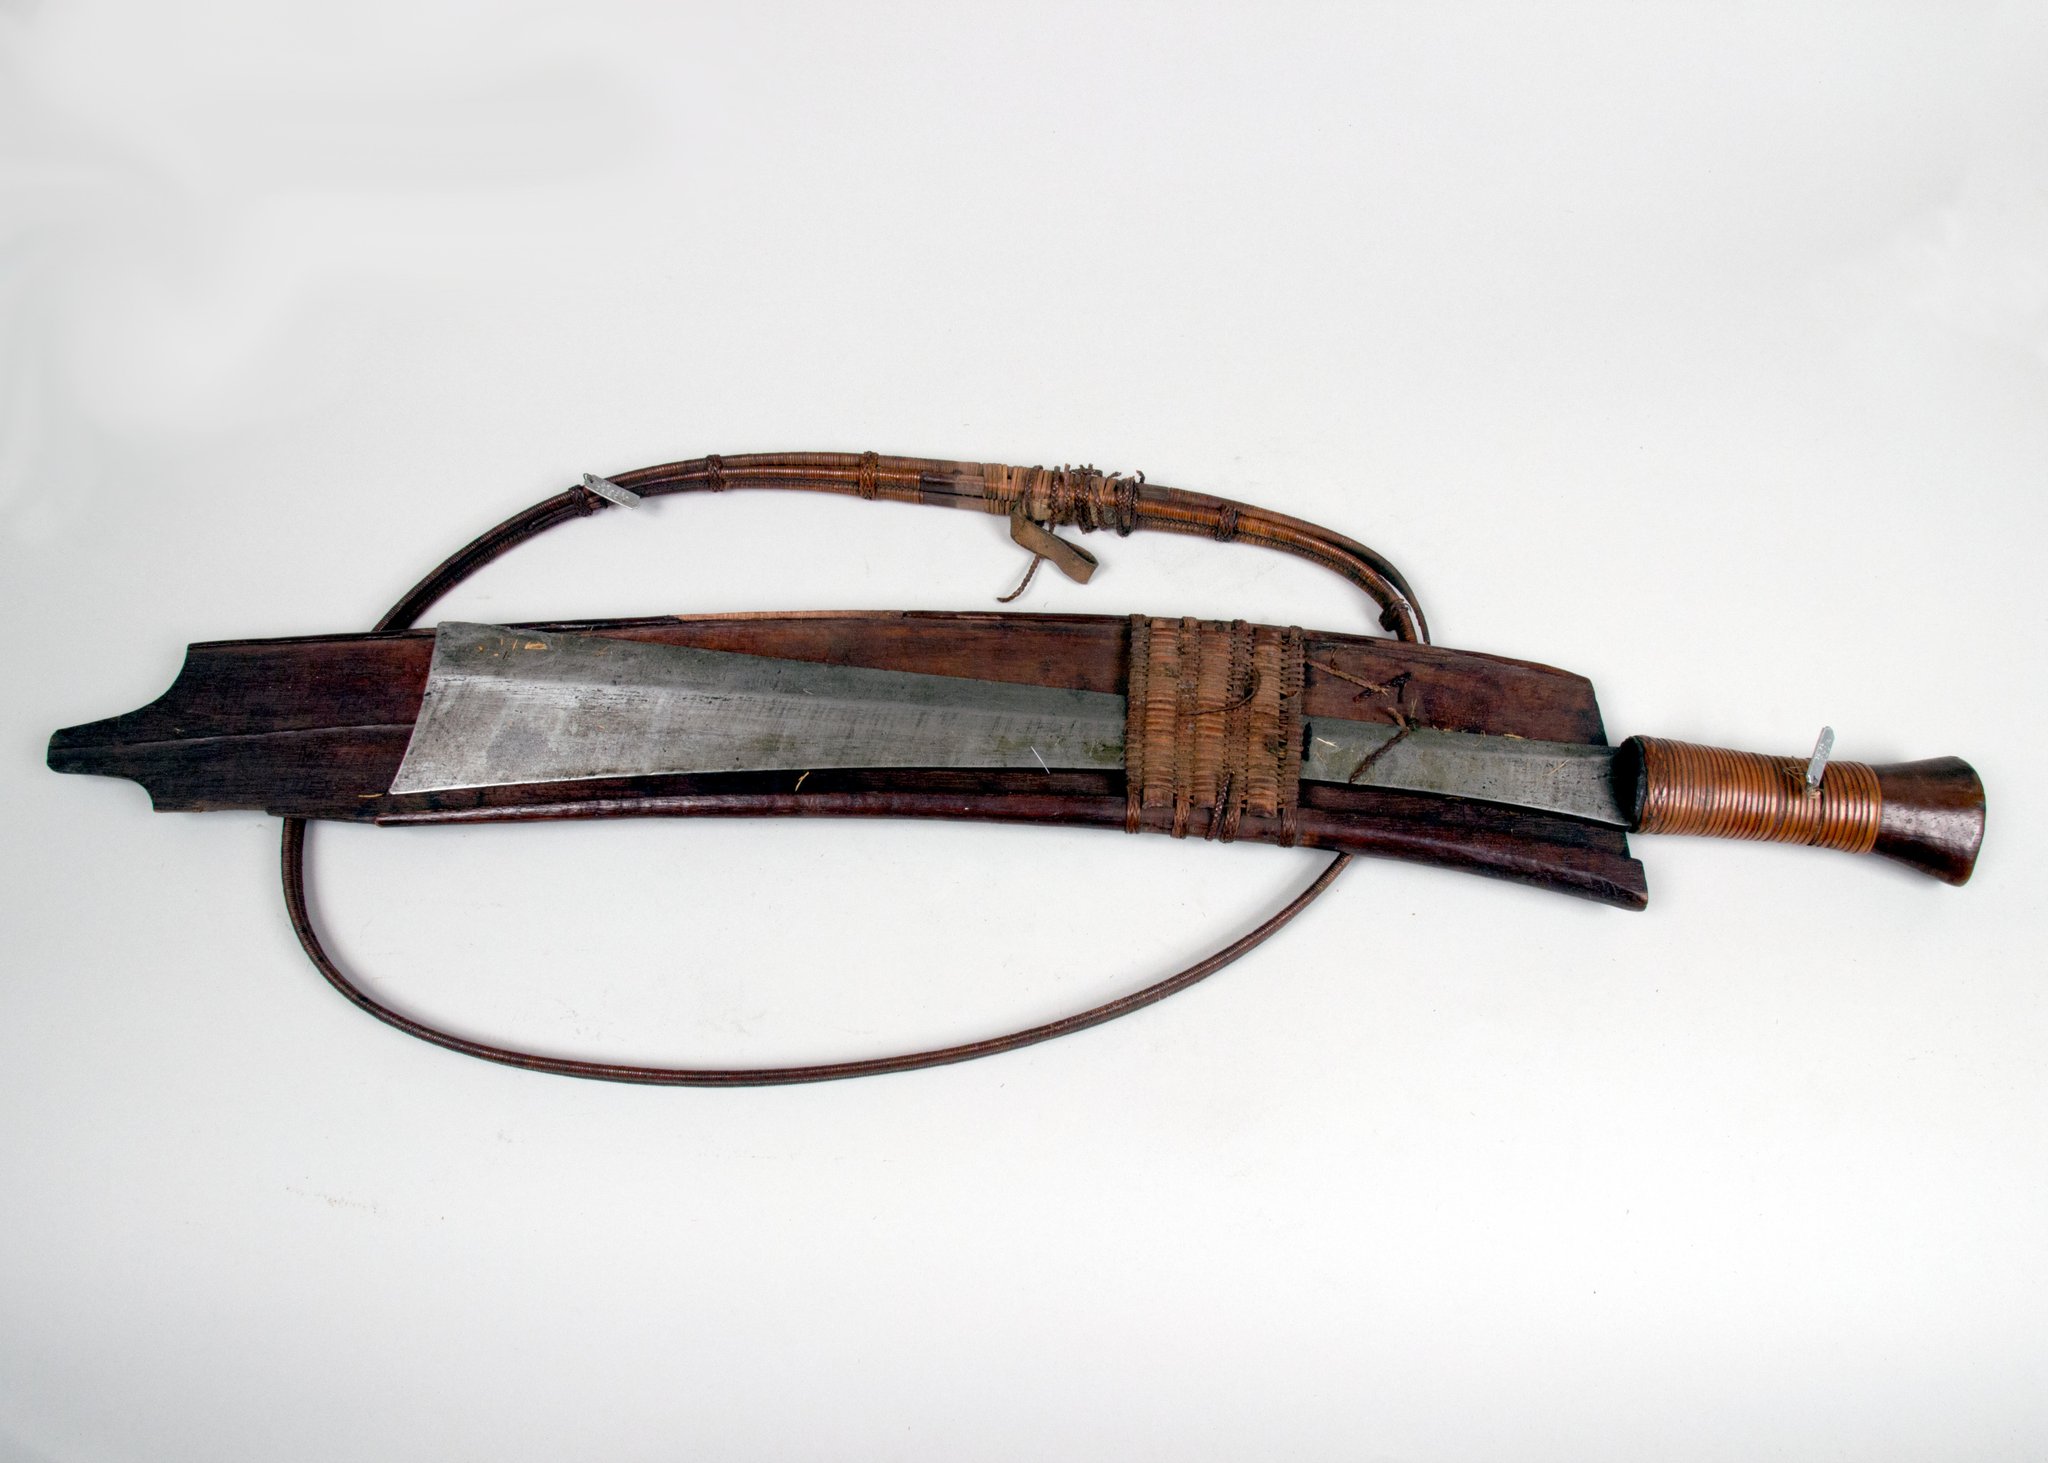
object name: sword dao with scabbard and baldric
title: Sword (Dao) with Scabbard and Baldric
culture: indian, assam or naga hills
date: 1801-1900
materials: steel, wood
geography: india